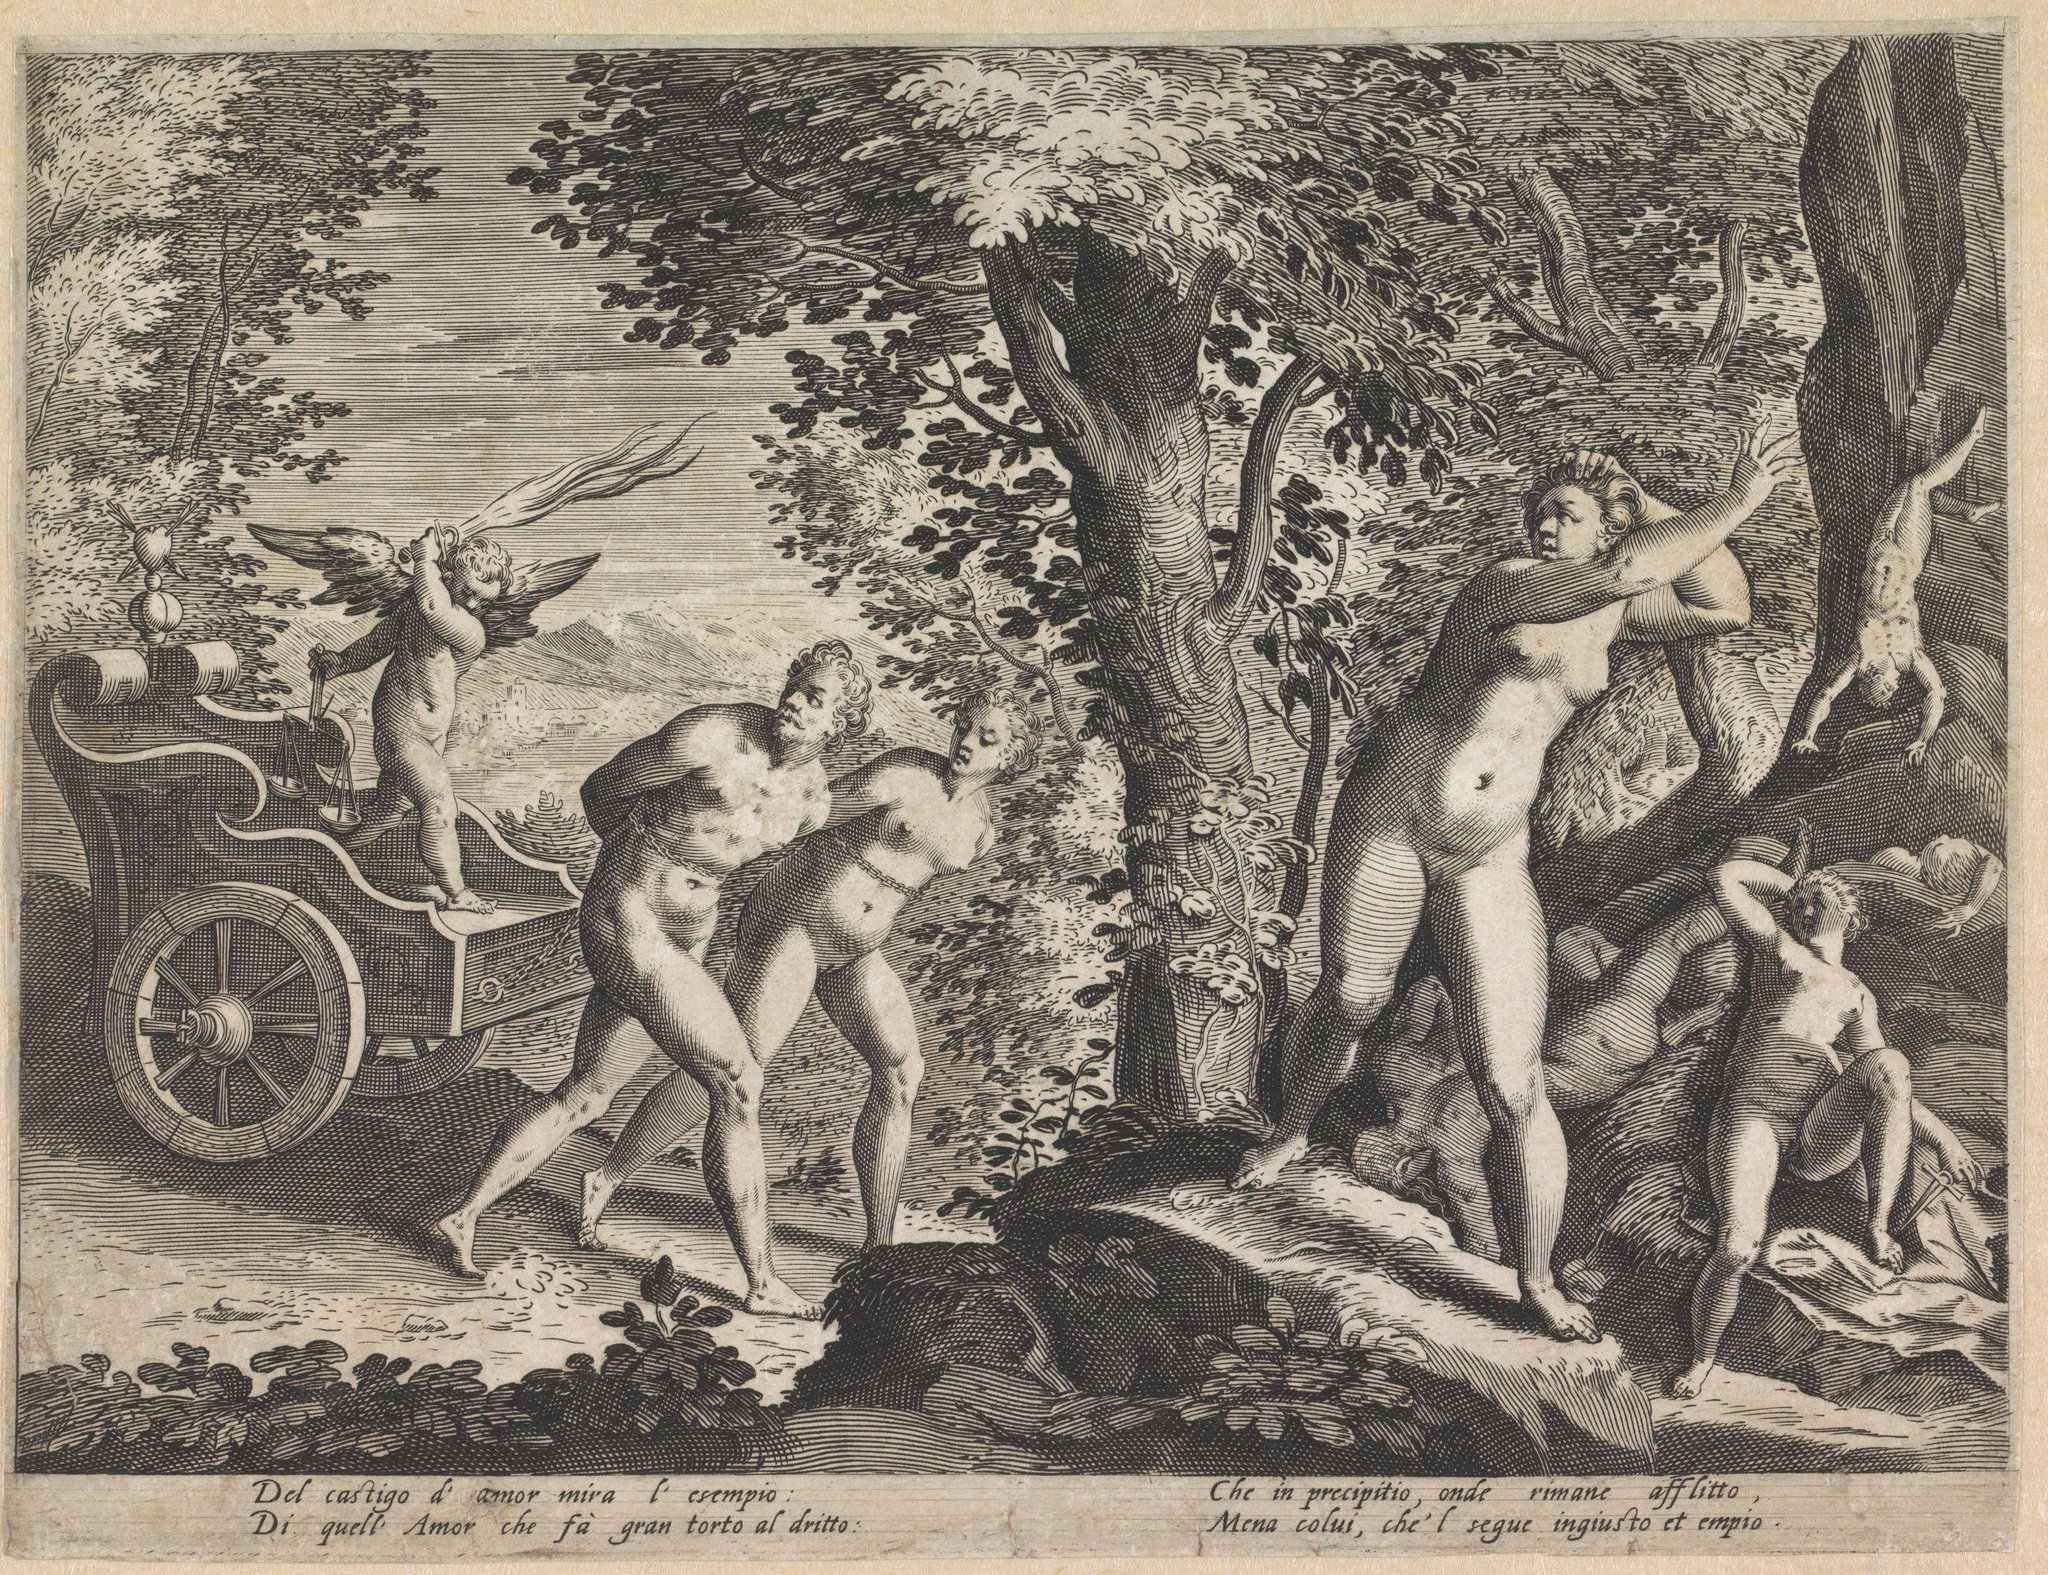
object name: print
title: Naakten voortgejaagd door Amor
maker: paolo fiammingo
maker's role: draughtsman, painter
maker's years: 1540-1596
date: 1589-1595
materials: paper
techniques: engraving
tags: chariot, triumphal car, (story of) cupid, amor (eros), seeking death, suicide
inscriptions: collector's mark: Lugt 2228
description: Een naakte man en vrouw (mogelijk Adam en Eva) zitten vastgeketend aan een kar met daarop Amor met een vlammend zwaard. Rechts een ongeruste figuur bij een groepje lichamen van mensen die zelfmoord hebben gepleegd. Naast een van de lichamen ligt een dolk en een ander lichaam valt langs een rotswand naar beneden. Italiaans vers in ondermarge.